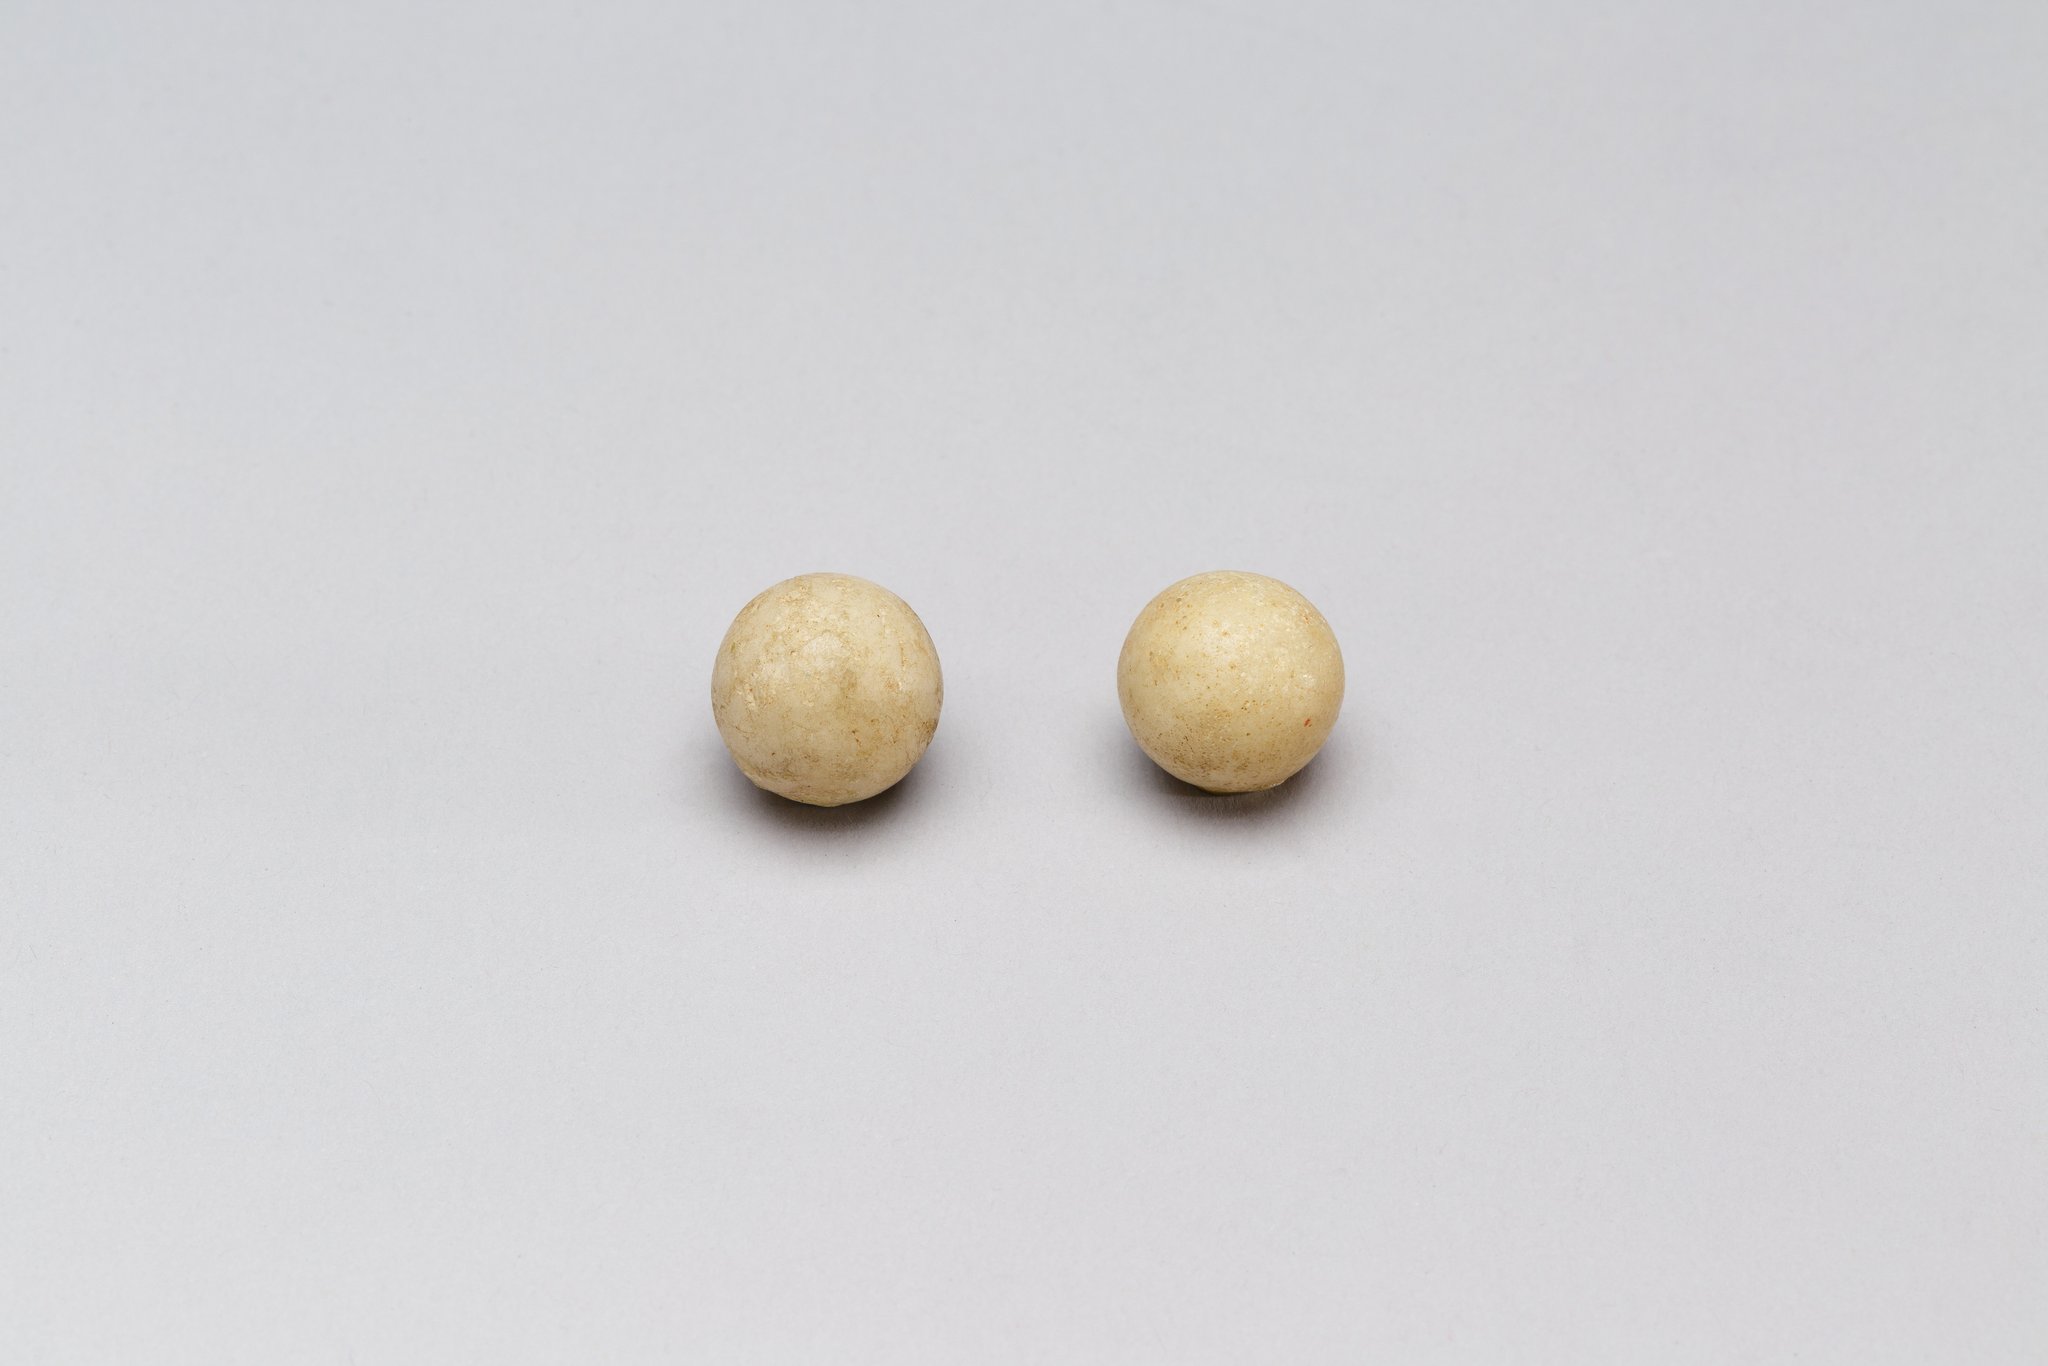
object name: game piece, marble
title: Marble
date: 3850-2300 BCE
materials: stone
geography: egypt